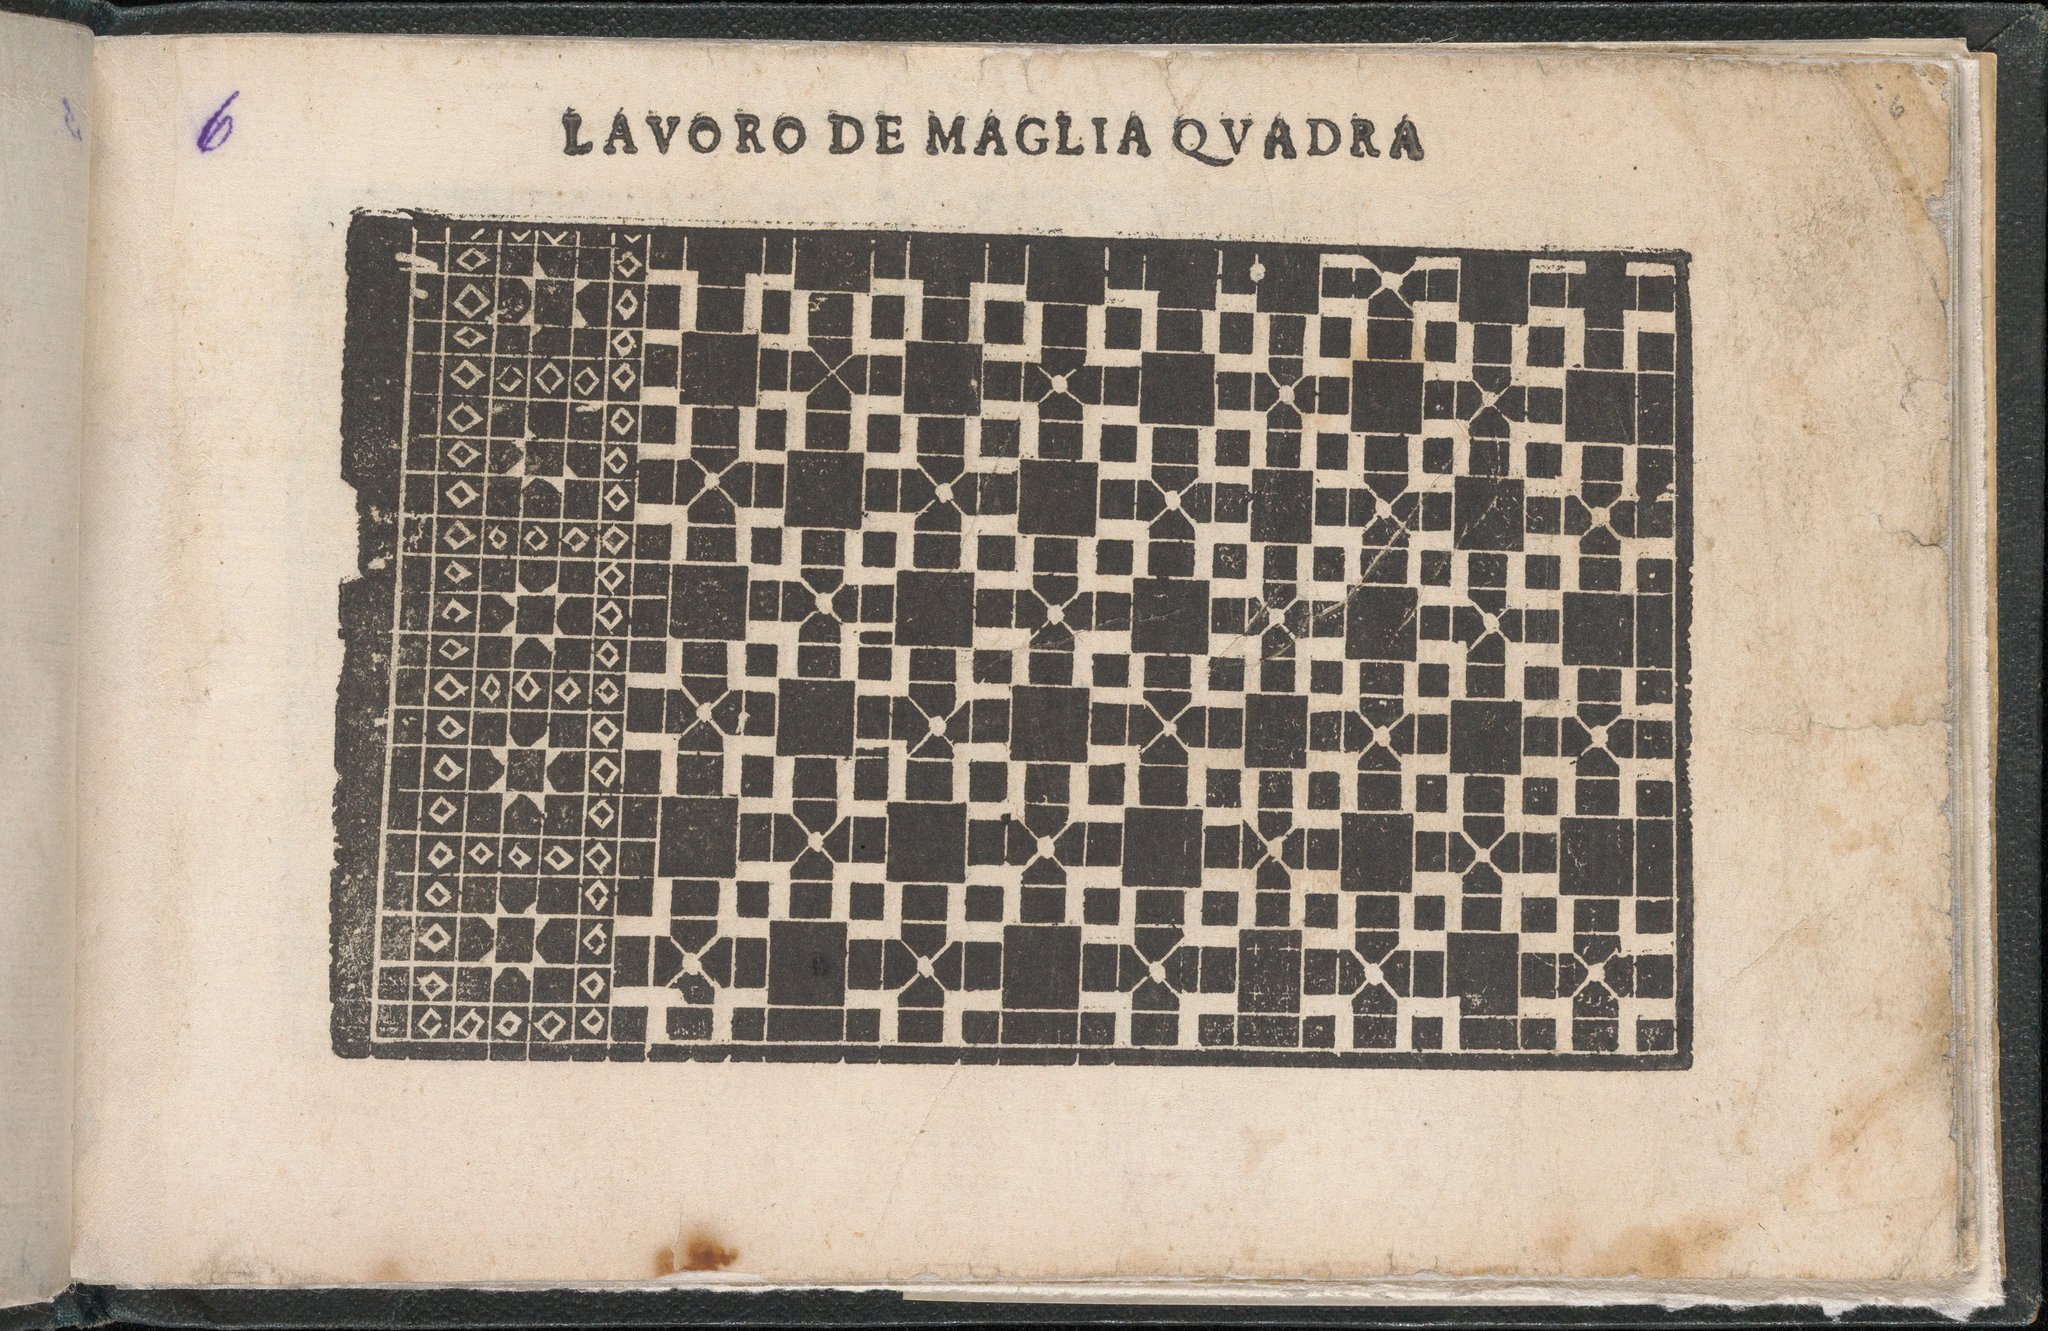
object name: book print ornament architecture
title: Gemma pretiosa della virtuose donne, page 6 (recto)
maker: isabella catanea parasole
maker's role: designer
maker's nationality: italian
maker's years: 1565-1625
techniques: woodcut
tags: ornament